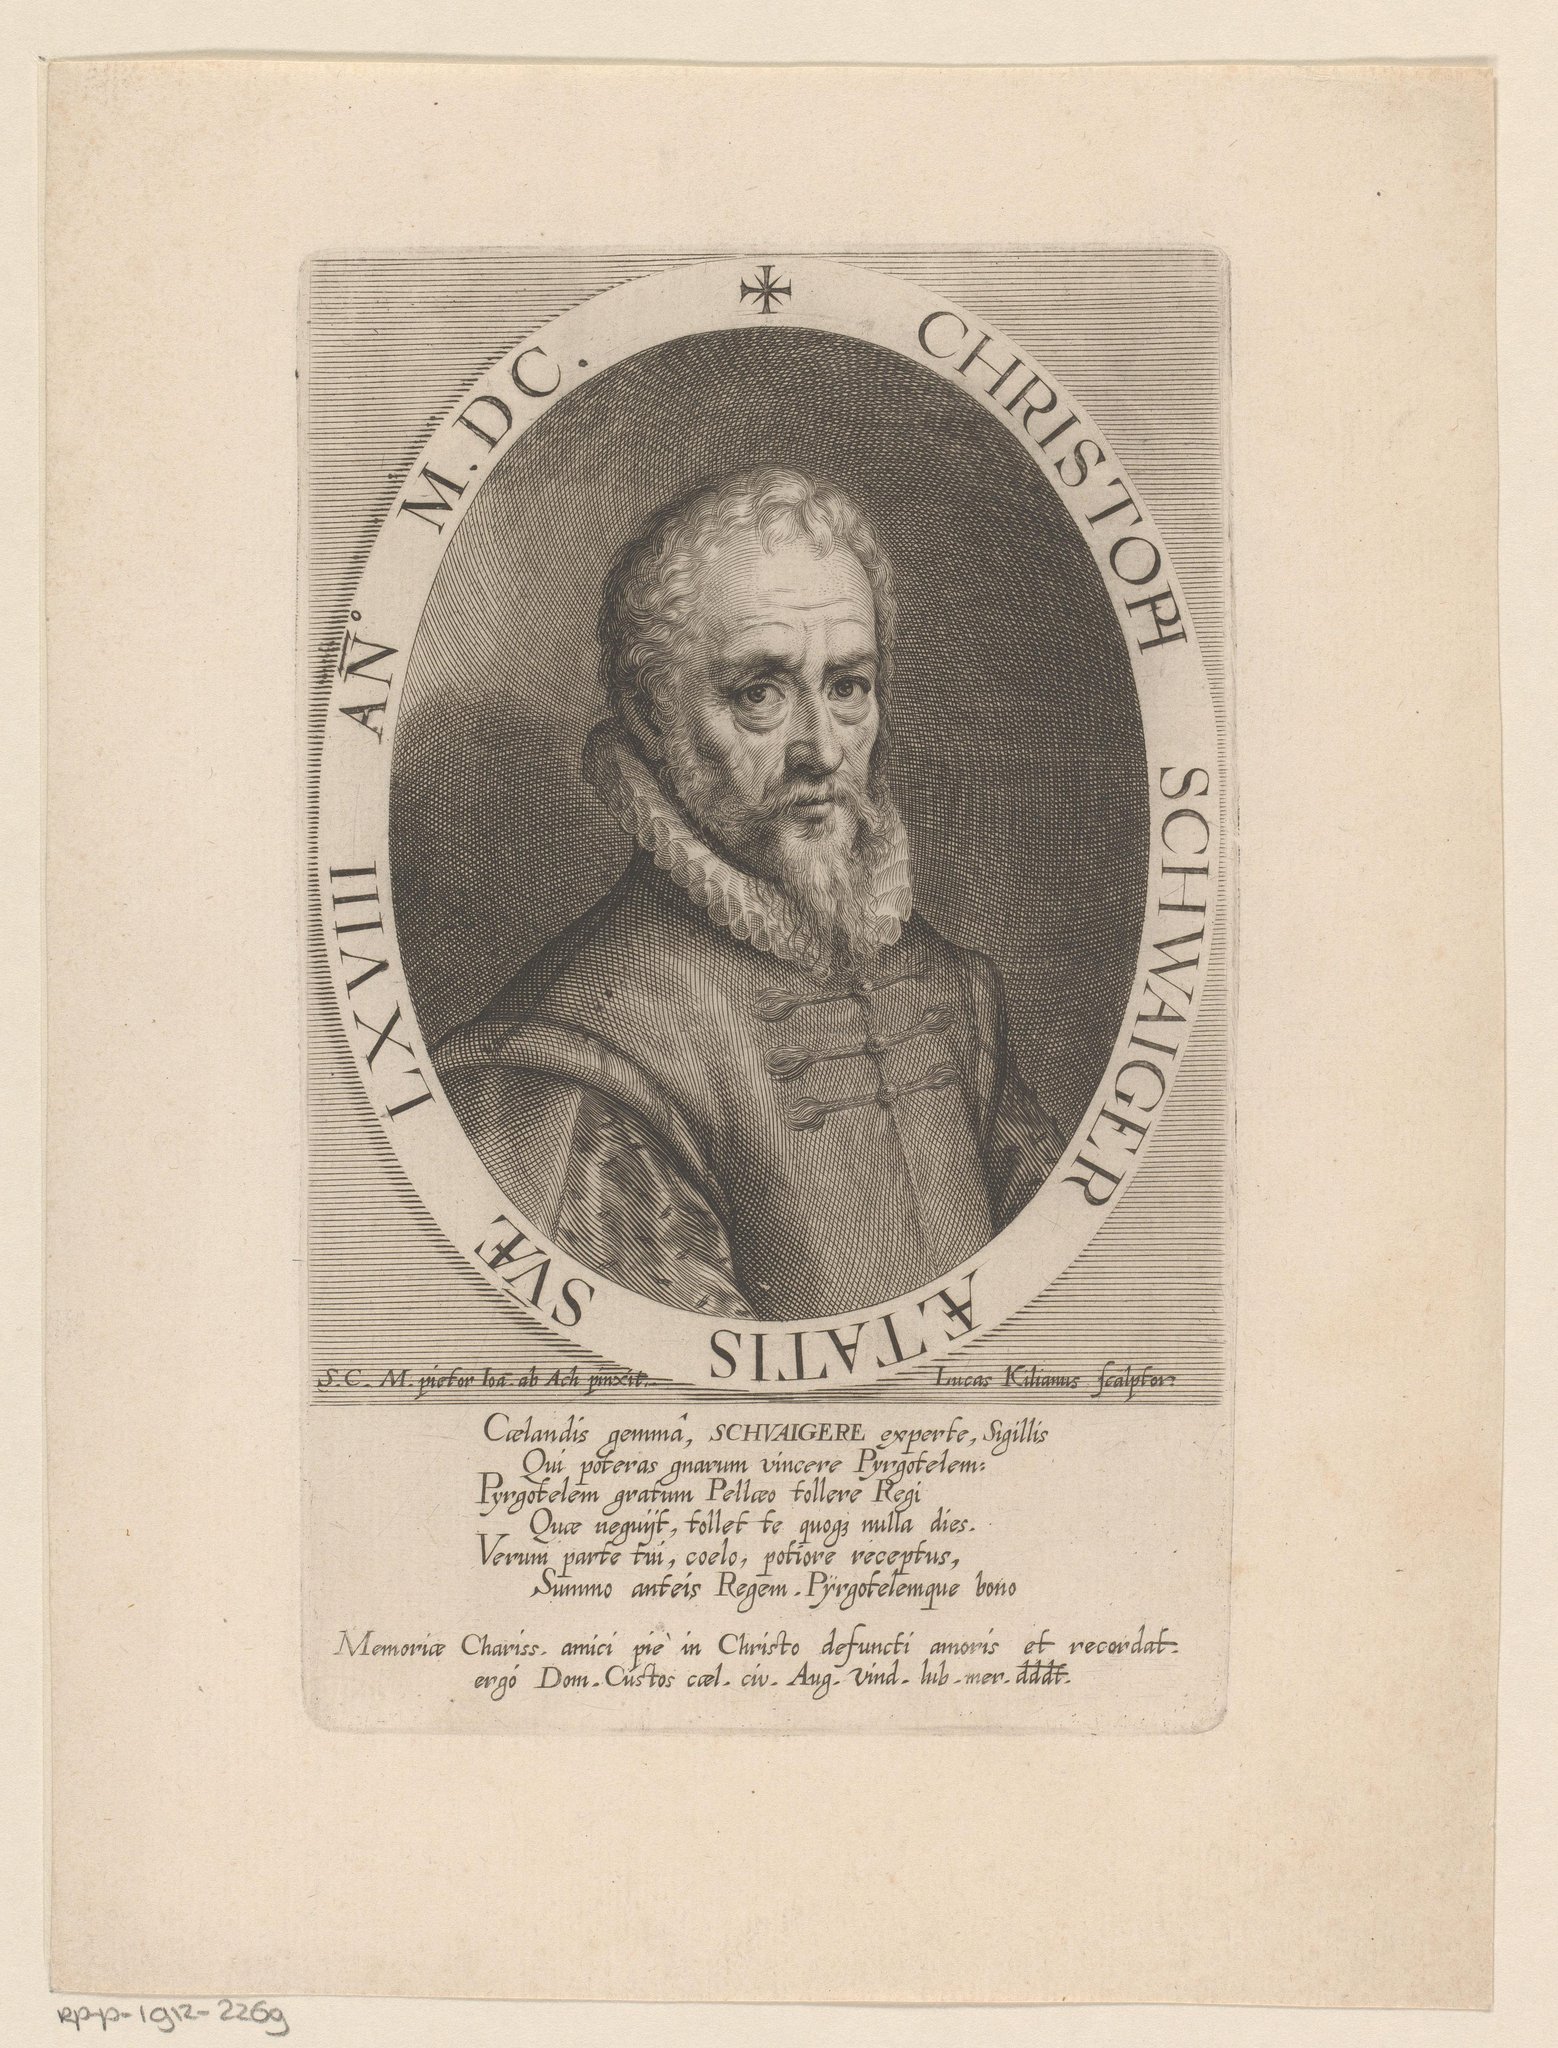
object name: print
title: Portret van Christoph Schwaiger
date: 1600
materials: paper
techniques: engraving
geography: augsburg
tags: christoph schwaiger, historical persons, jeweller, goldsmith, silversmith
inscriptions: collector's mark: Lugt 2228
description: Met achtregelig onderschrift in het Latijn en tekst in het Latijn rondom het portret.